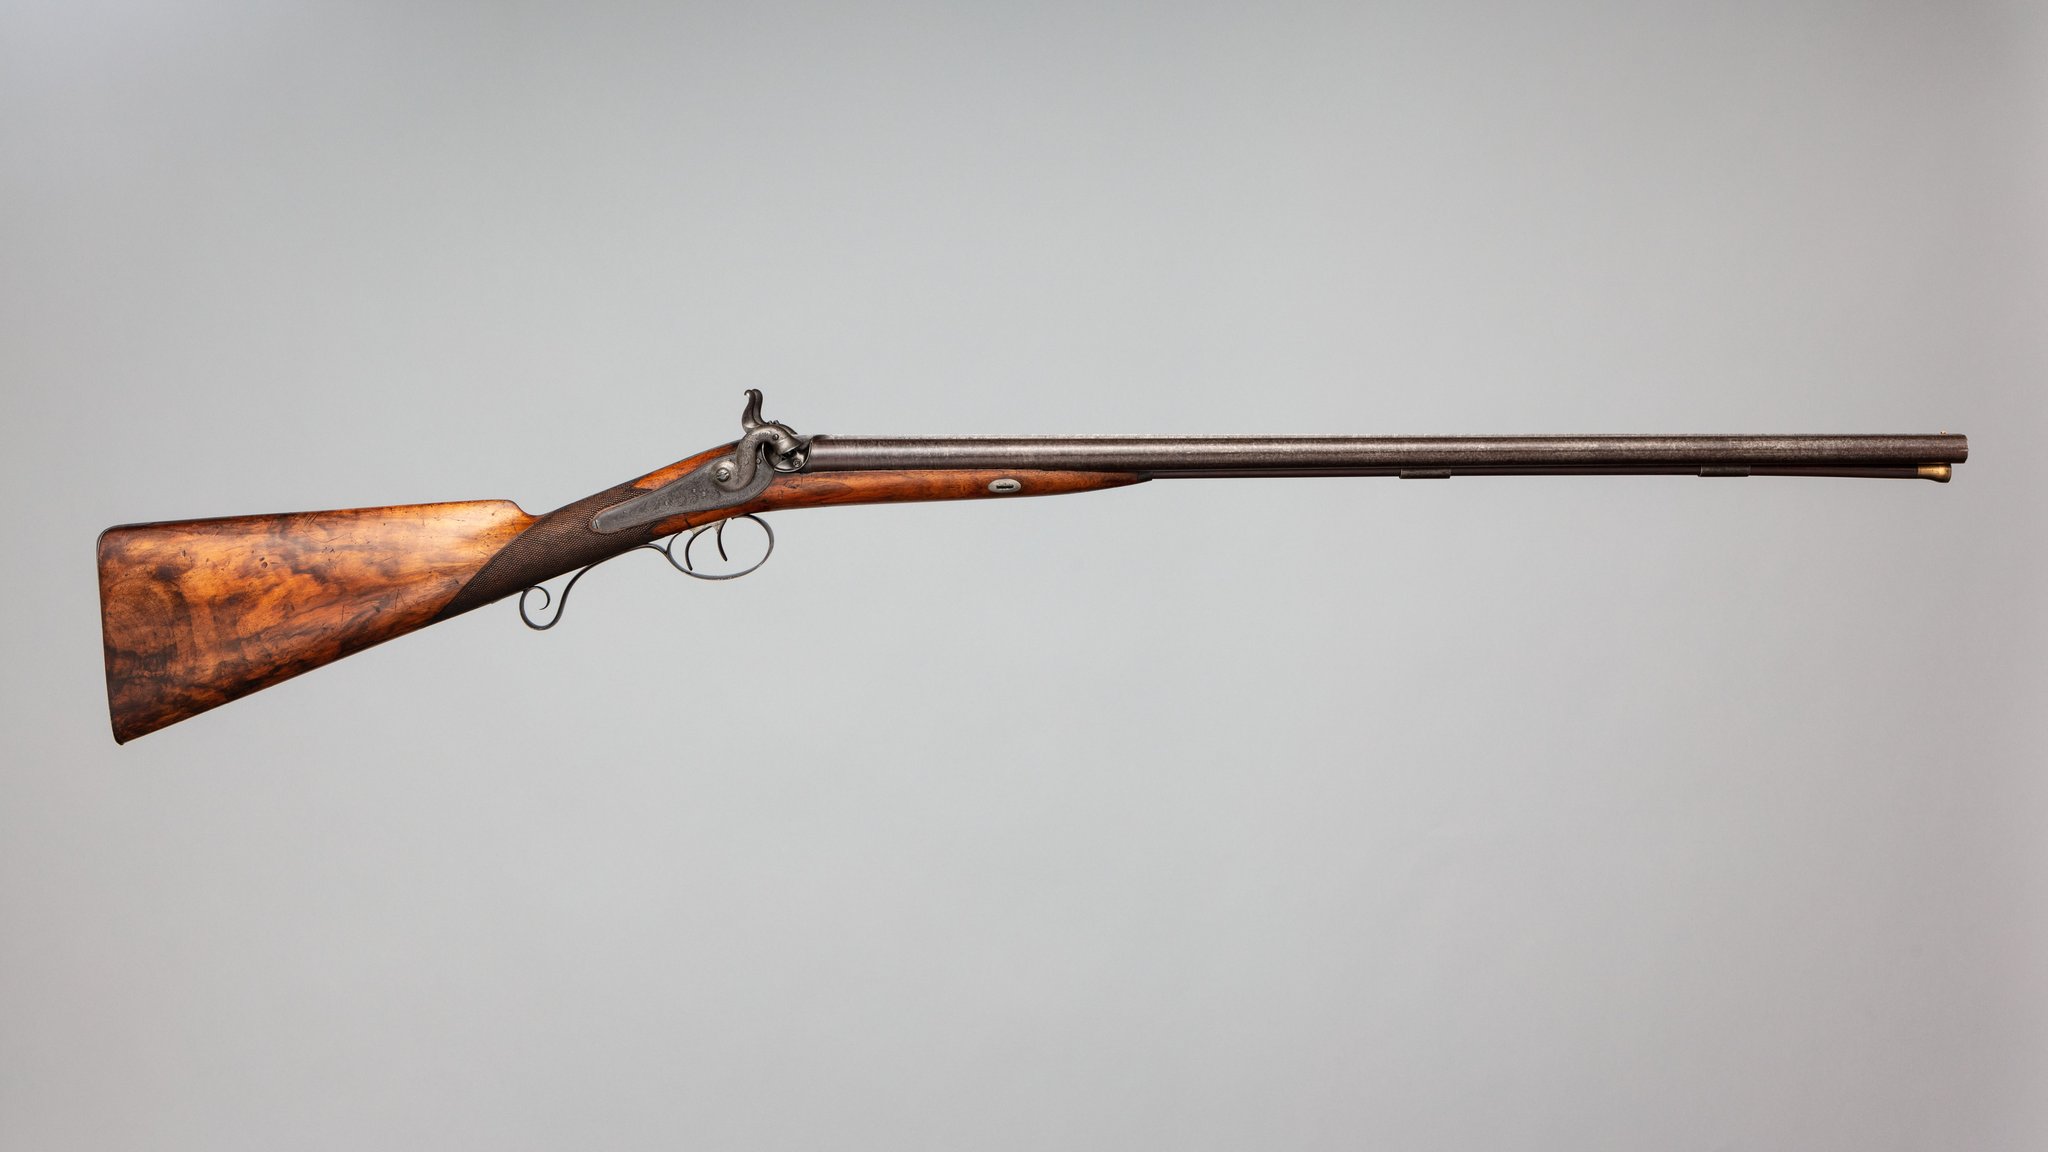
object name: percussion shotgun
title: Side-by-Side Self-Priming Pellet-Lock Shotgun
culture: british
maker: joseph egg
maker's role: gunsmith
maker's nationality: british, born france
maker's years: 1775-1837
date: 1835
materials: brass, steel, wood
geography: england